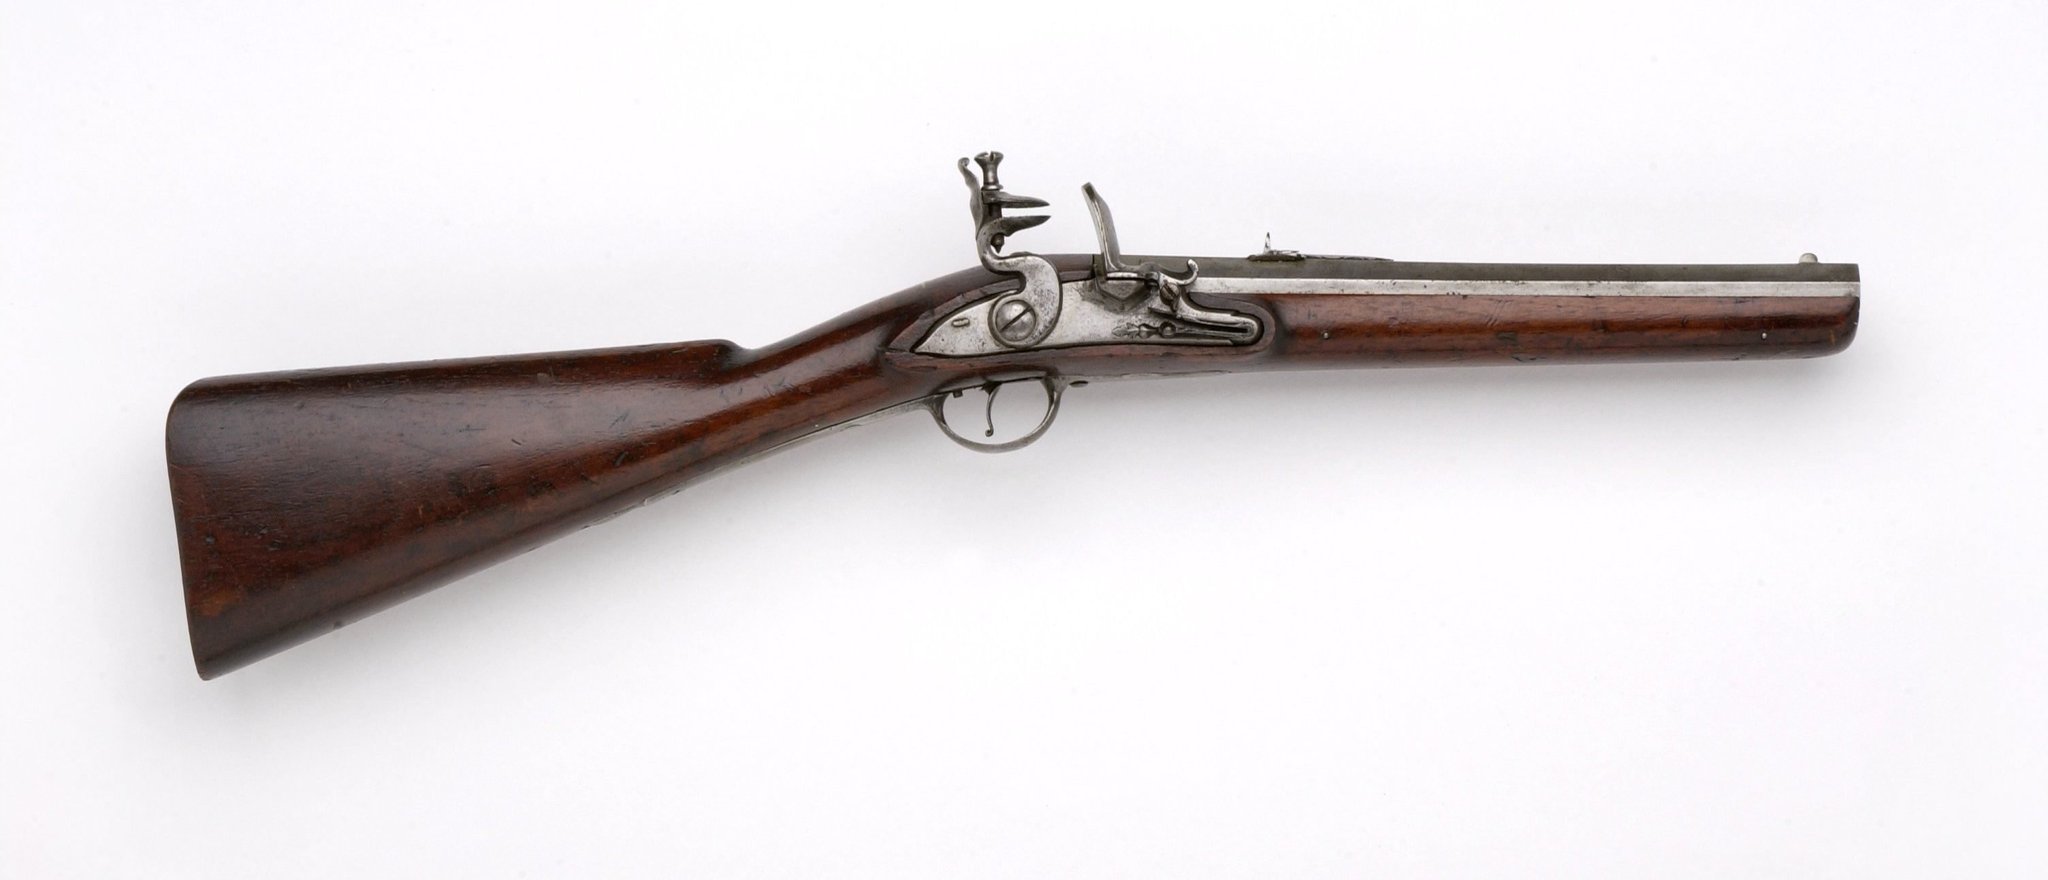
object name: flintlock pistol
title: Vuursteenruiterkarabijn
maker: van gellecum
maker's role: geweermaker, pistoolmaker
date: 1725-1750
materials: iron, paint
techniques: cutting, engraving, striking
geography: utrecht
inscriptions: signature: ‘VAN GELLECUM + UTRECHT’, number: ‘7/31’